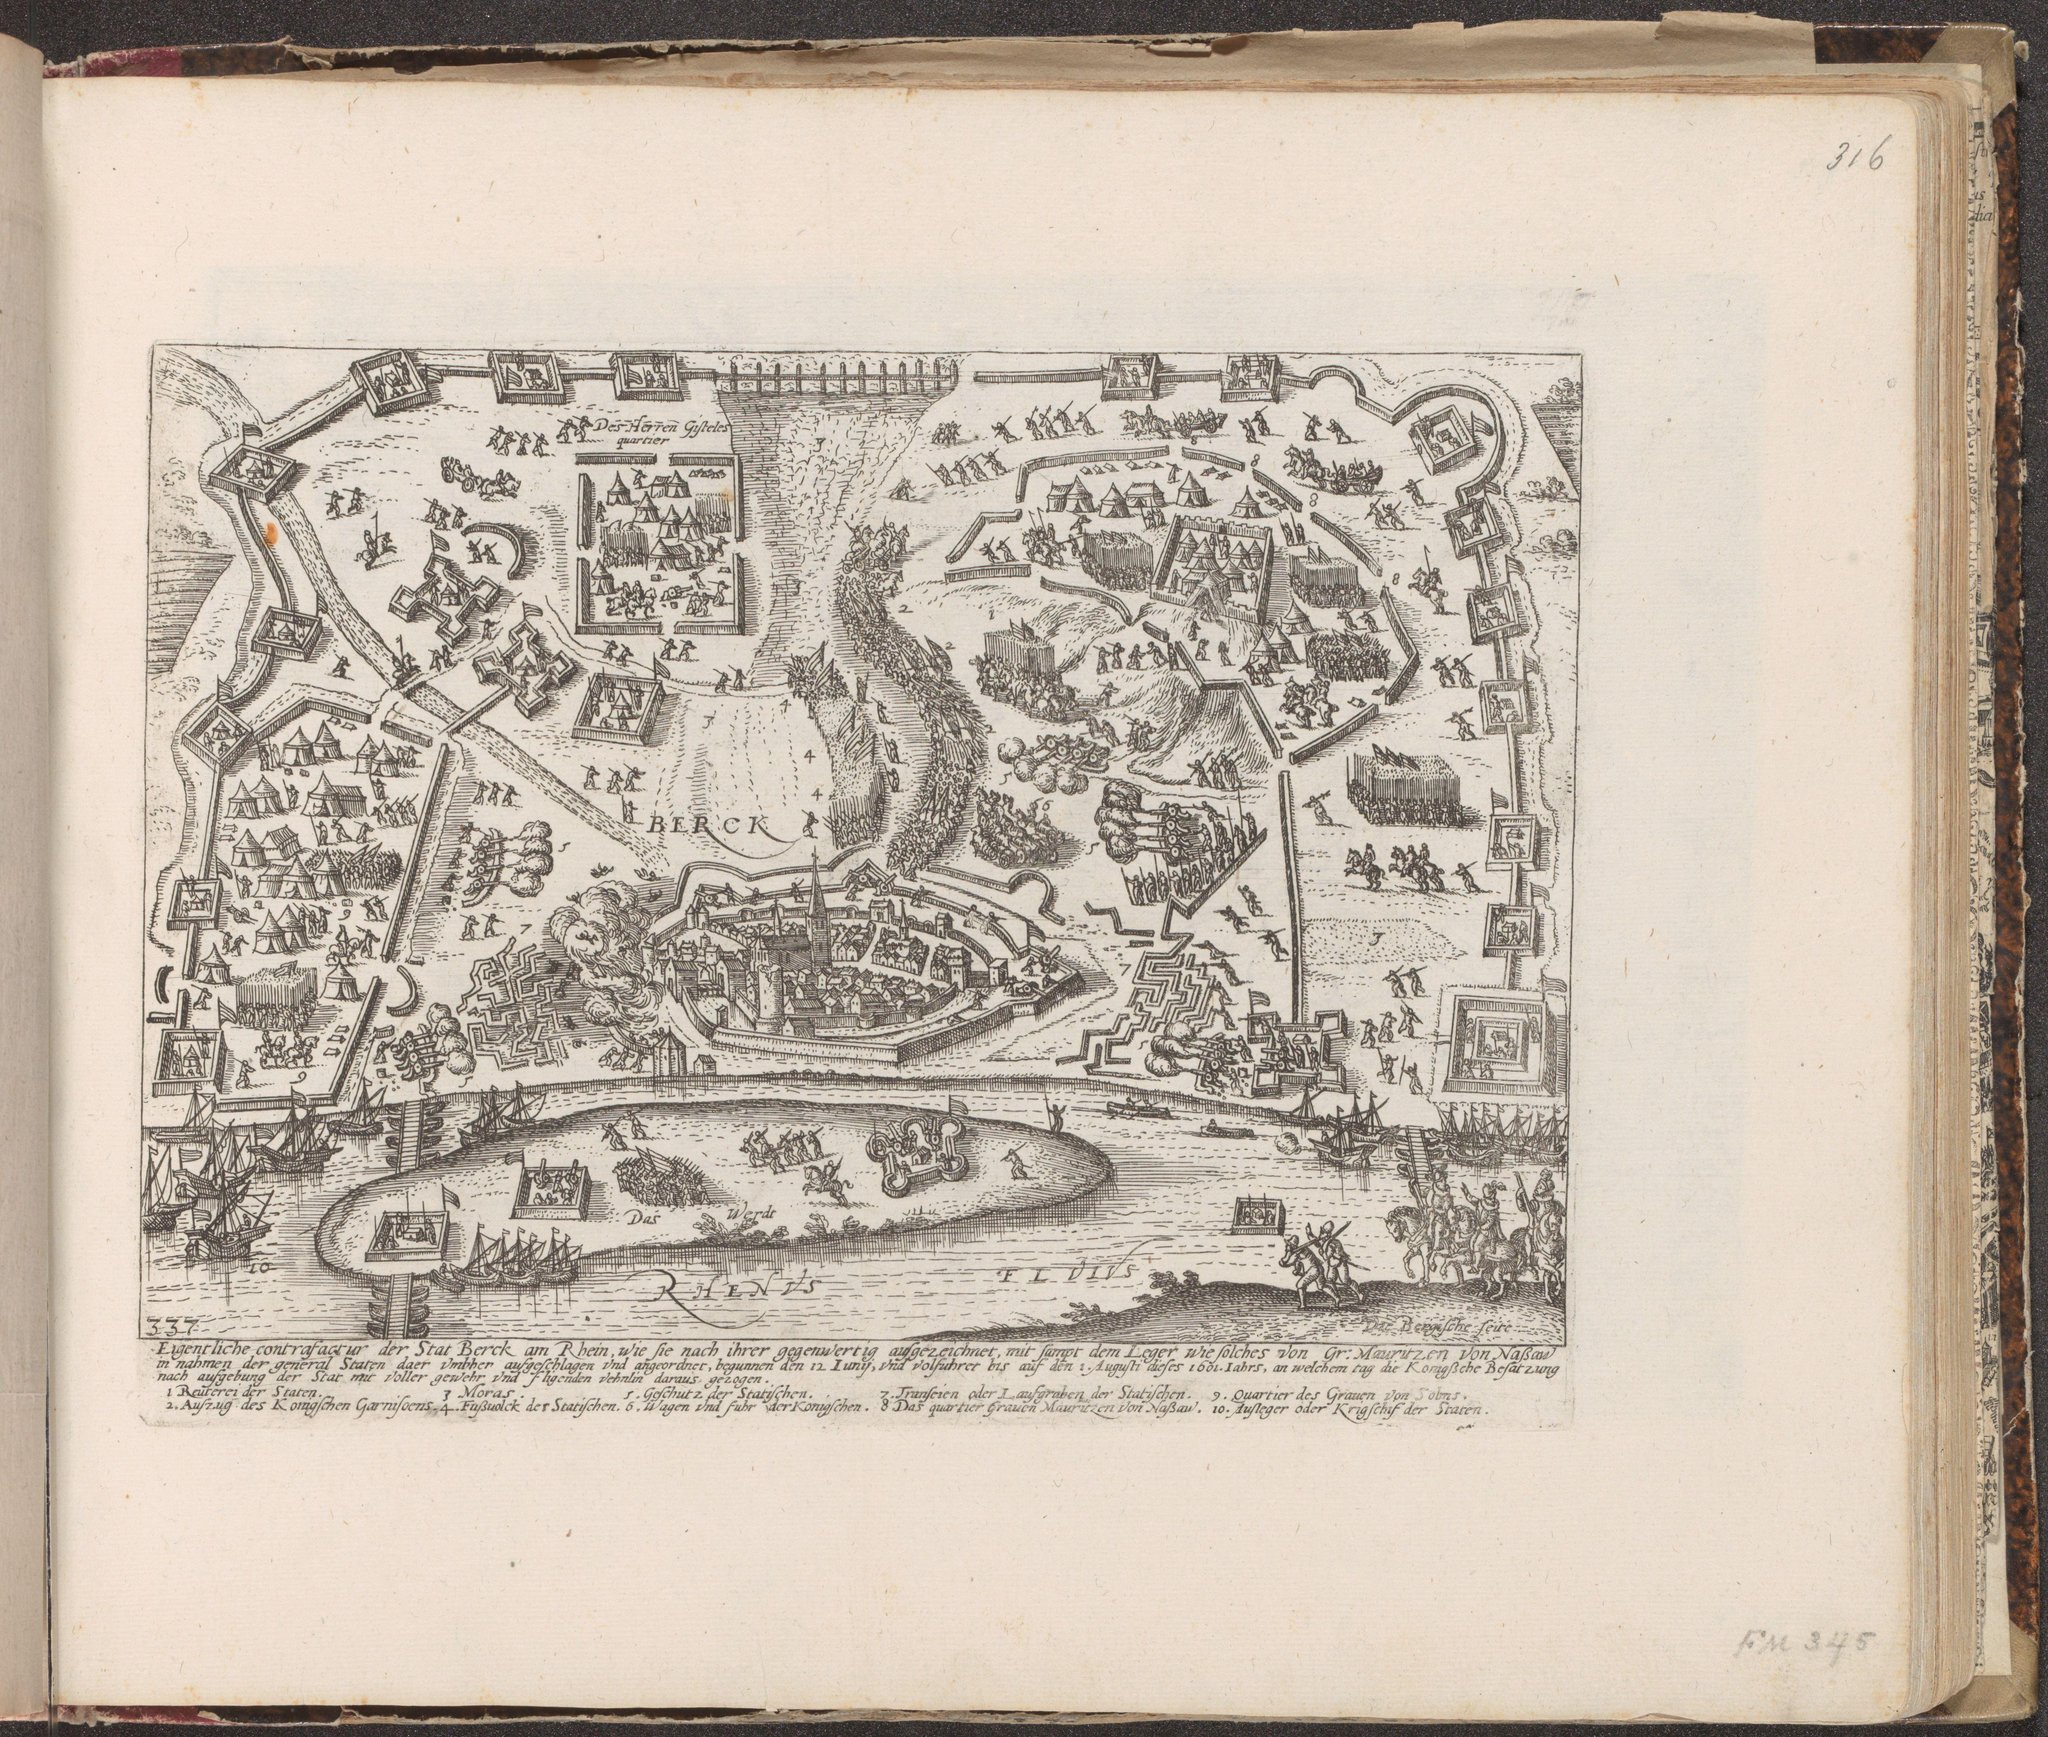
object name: print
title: Inname van Rheinberg, 1601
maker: frans hogenberg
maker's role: print maker, publisher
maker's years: 1538-1590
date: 1601-1603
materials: paper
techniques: etching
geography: cologne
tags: capture of city (after the siege)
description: Inname van Rheinberg door het Staatse leger onder prins Maurits en het vertrek van de Spaanse troepen, 1 augustus 1601. Plan van de stad en omgeving met de stellingen van de belegeraars. Onder de voorstelling de titel en de legenda van de cijfers 1-10, in het Duits. Linksonder genummerd: 337. De prent maakt deel uit van een album.